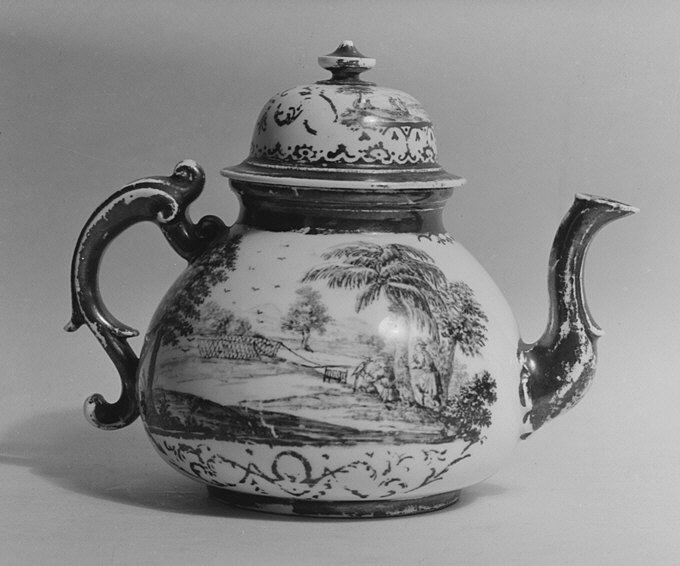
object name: teapot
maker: meissen manufactory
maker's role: manufactory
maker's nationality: german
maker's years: 1710-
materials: hard paste porcelain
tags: landscapes,trees